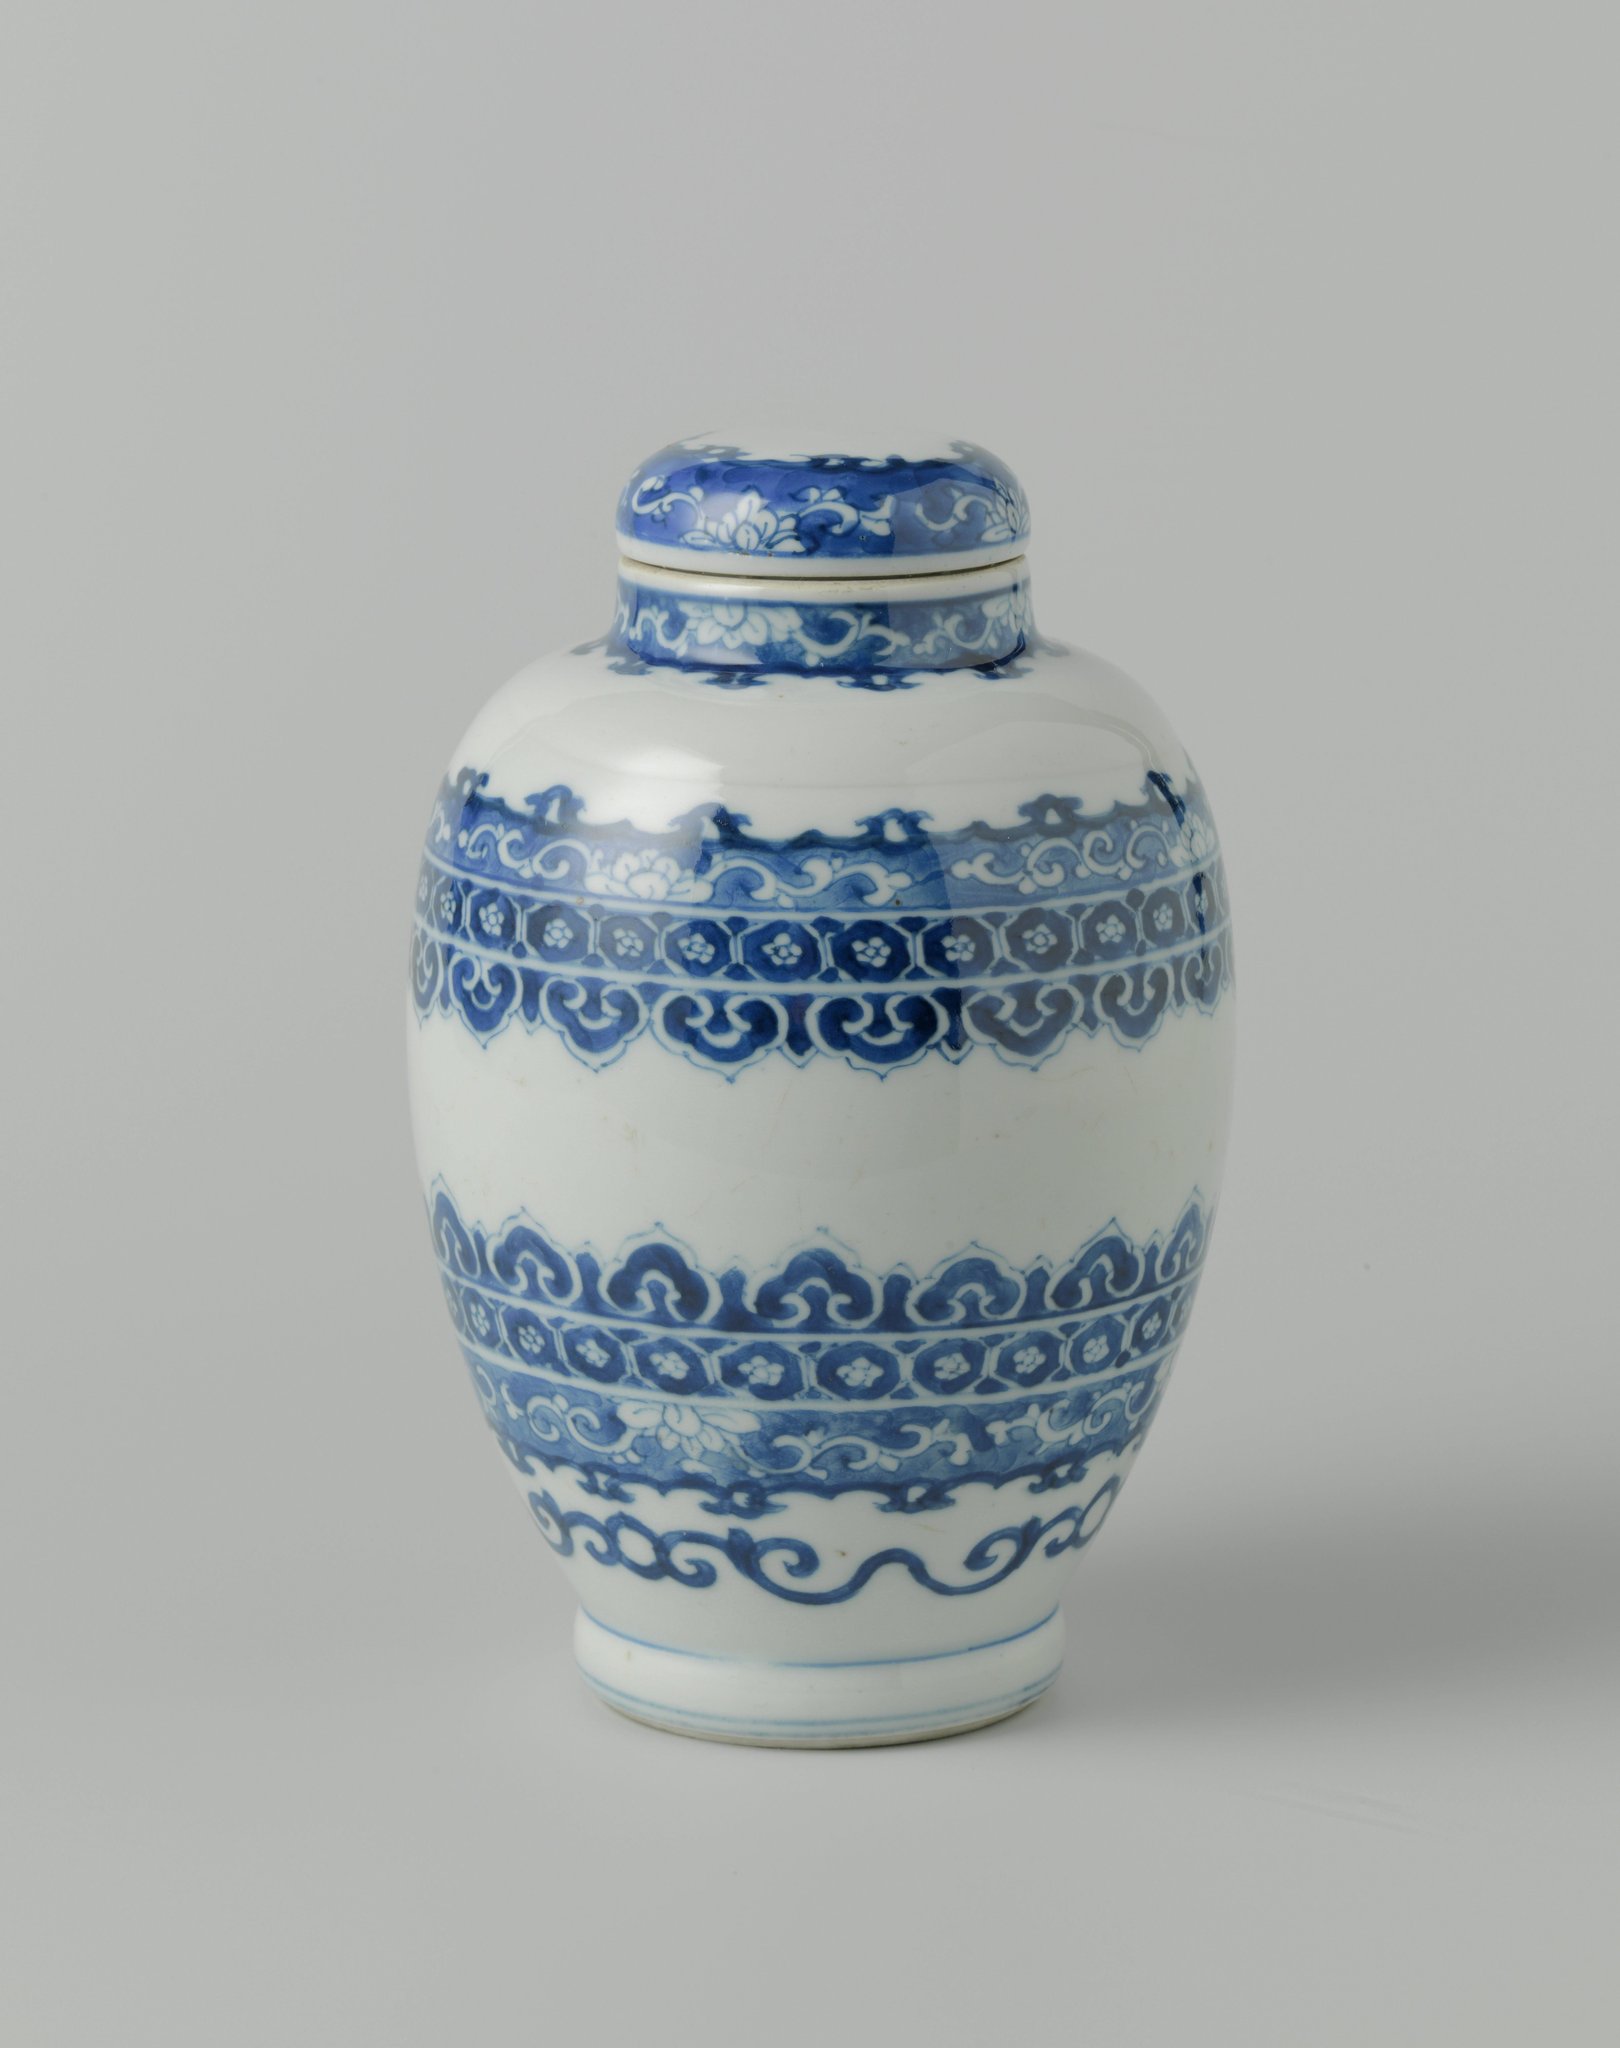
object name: covered jar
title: Ovoid covered jar with ornamental borders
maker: Anonymous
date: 1675-1699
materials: cobalt, glaze, paint, porcelain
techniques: firing, turning, vitrification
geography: china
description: Eivormige dekselpot van porselein, beschilderd in onderglazuur blauw. Op de buik een brede band opgebouwd uit drie verschillende smallere banden met lotusranken uitgespaard in een blauwe achtergrond, één met kleine bloemrozetten en één met ruyi-motieven. Hierboven dezelfde band in omgekeerde volgorde. Boven de voet een rank. Op de korte hals en het deksel lotusranken uitgespaard in een blauwe achtergrond. Blauw-wit.